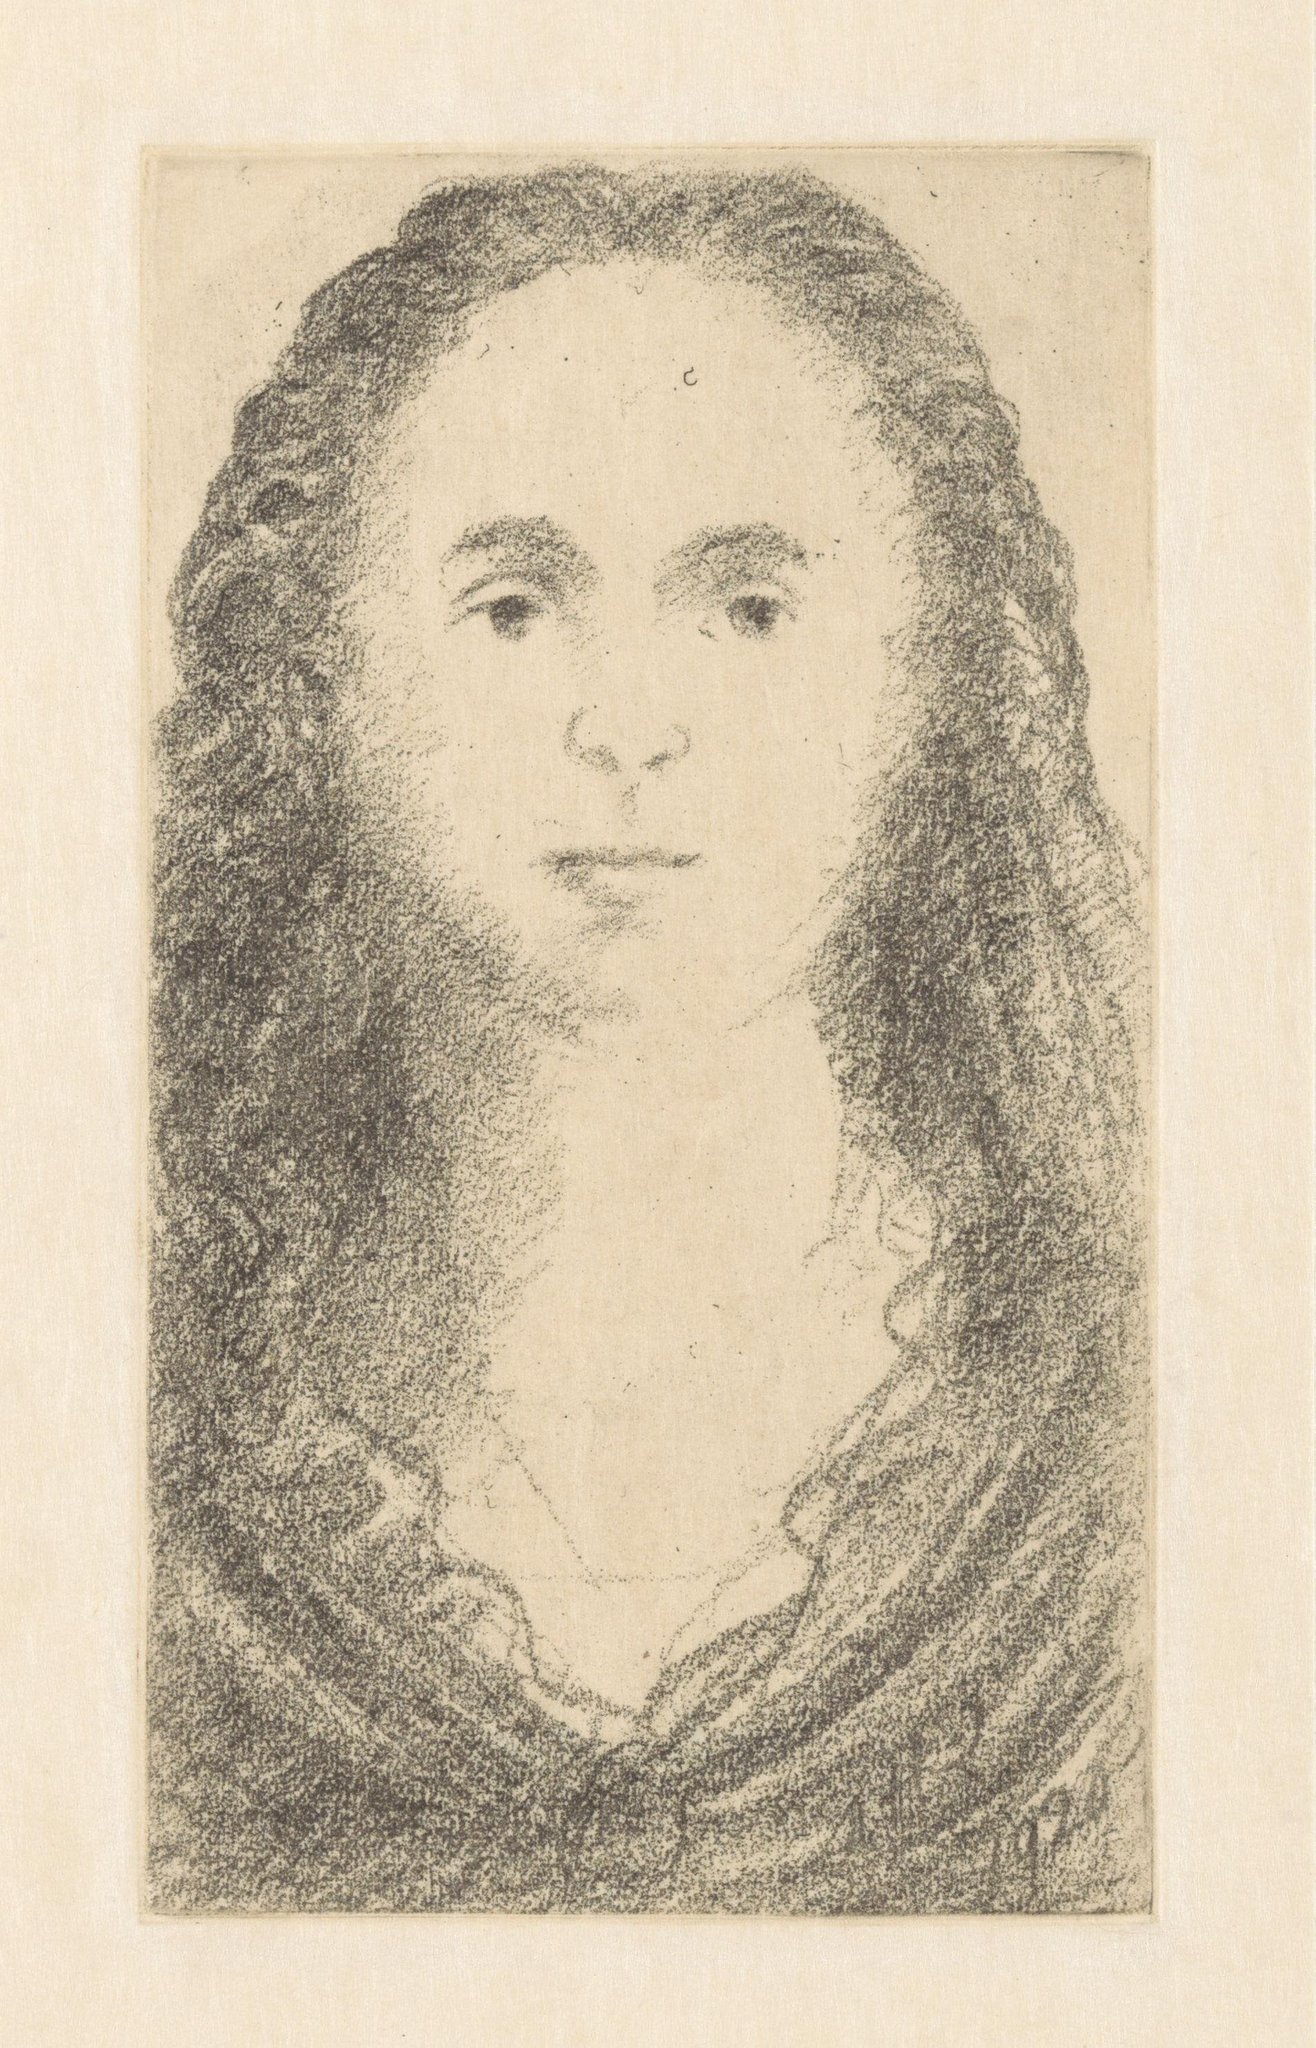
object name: print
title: Jonge vrouw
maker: marius holleman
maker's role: draughtsman, print maker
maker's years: 1878-1926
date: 1920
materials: paper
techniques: etching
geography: groningen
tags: adolescent, young woman, maiden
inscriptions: collector's mark: Lugt 2228